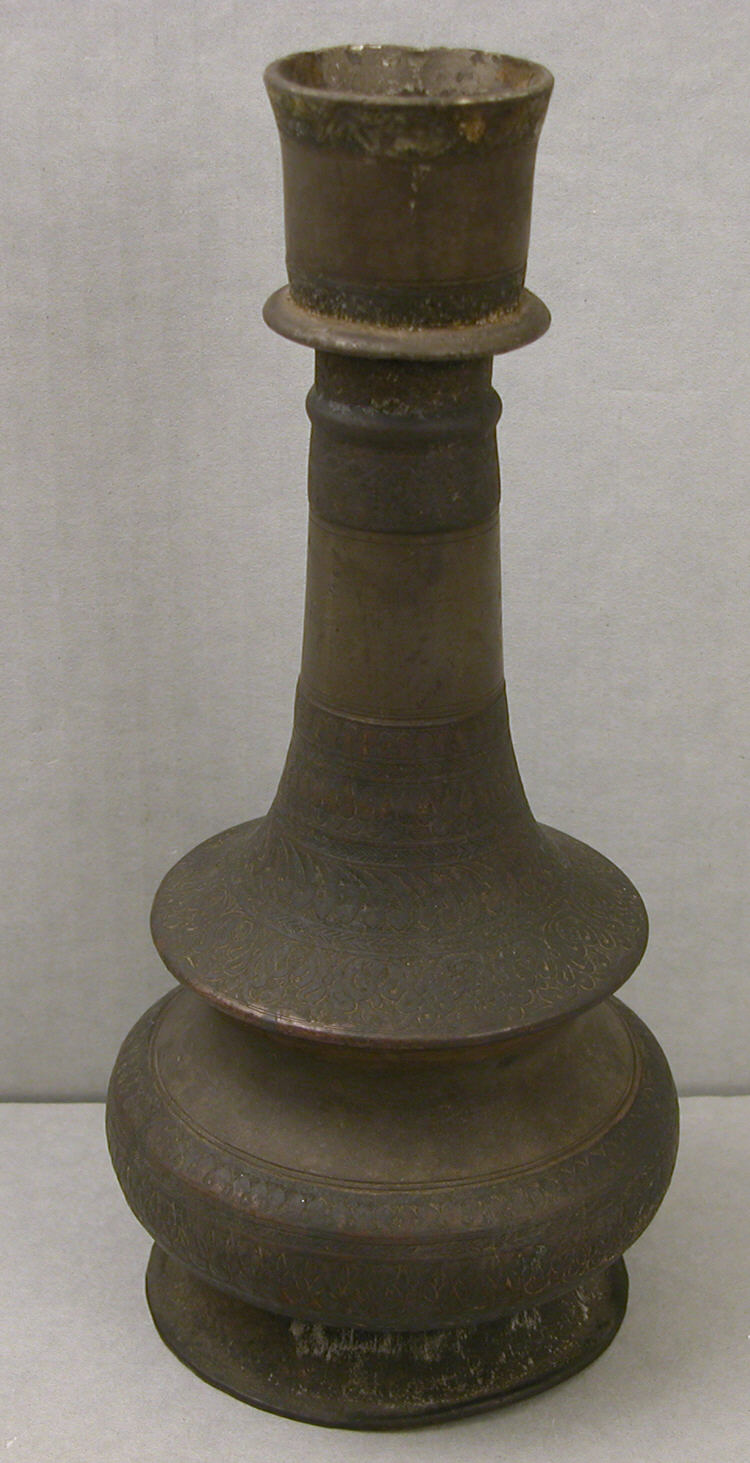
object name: bottle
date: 1601-1800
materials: metal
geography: india